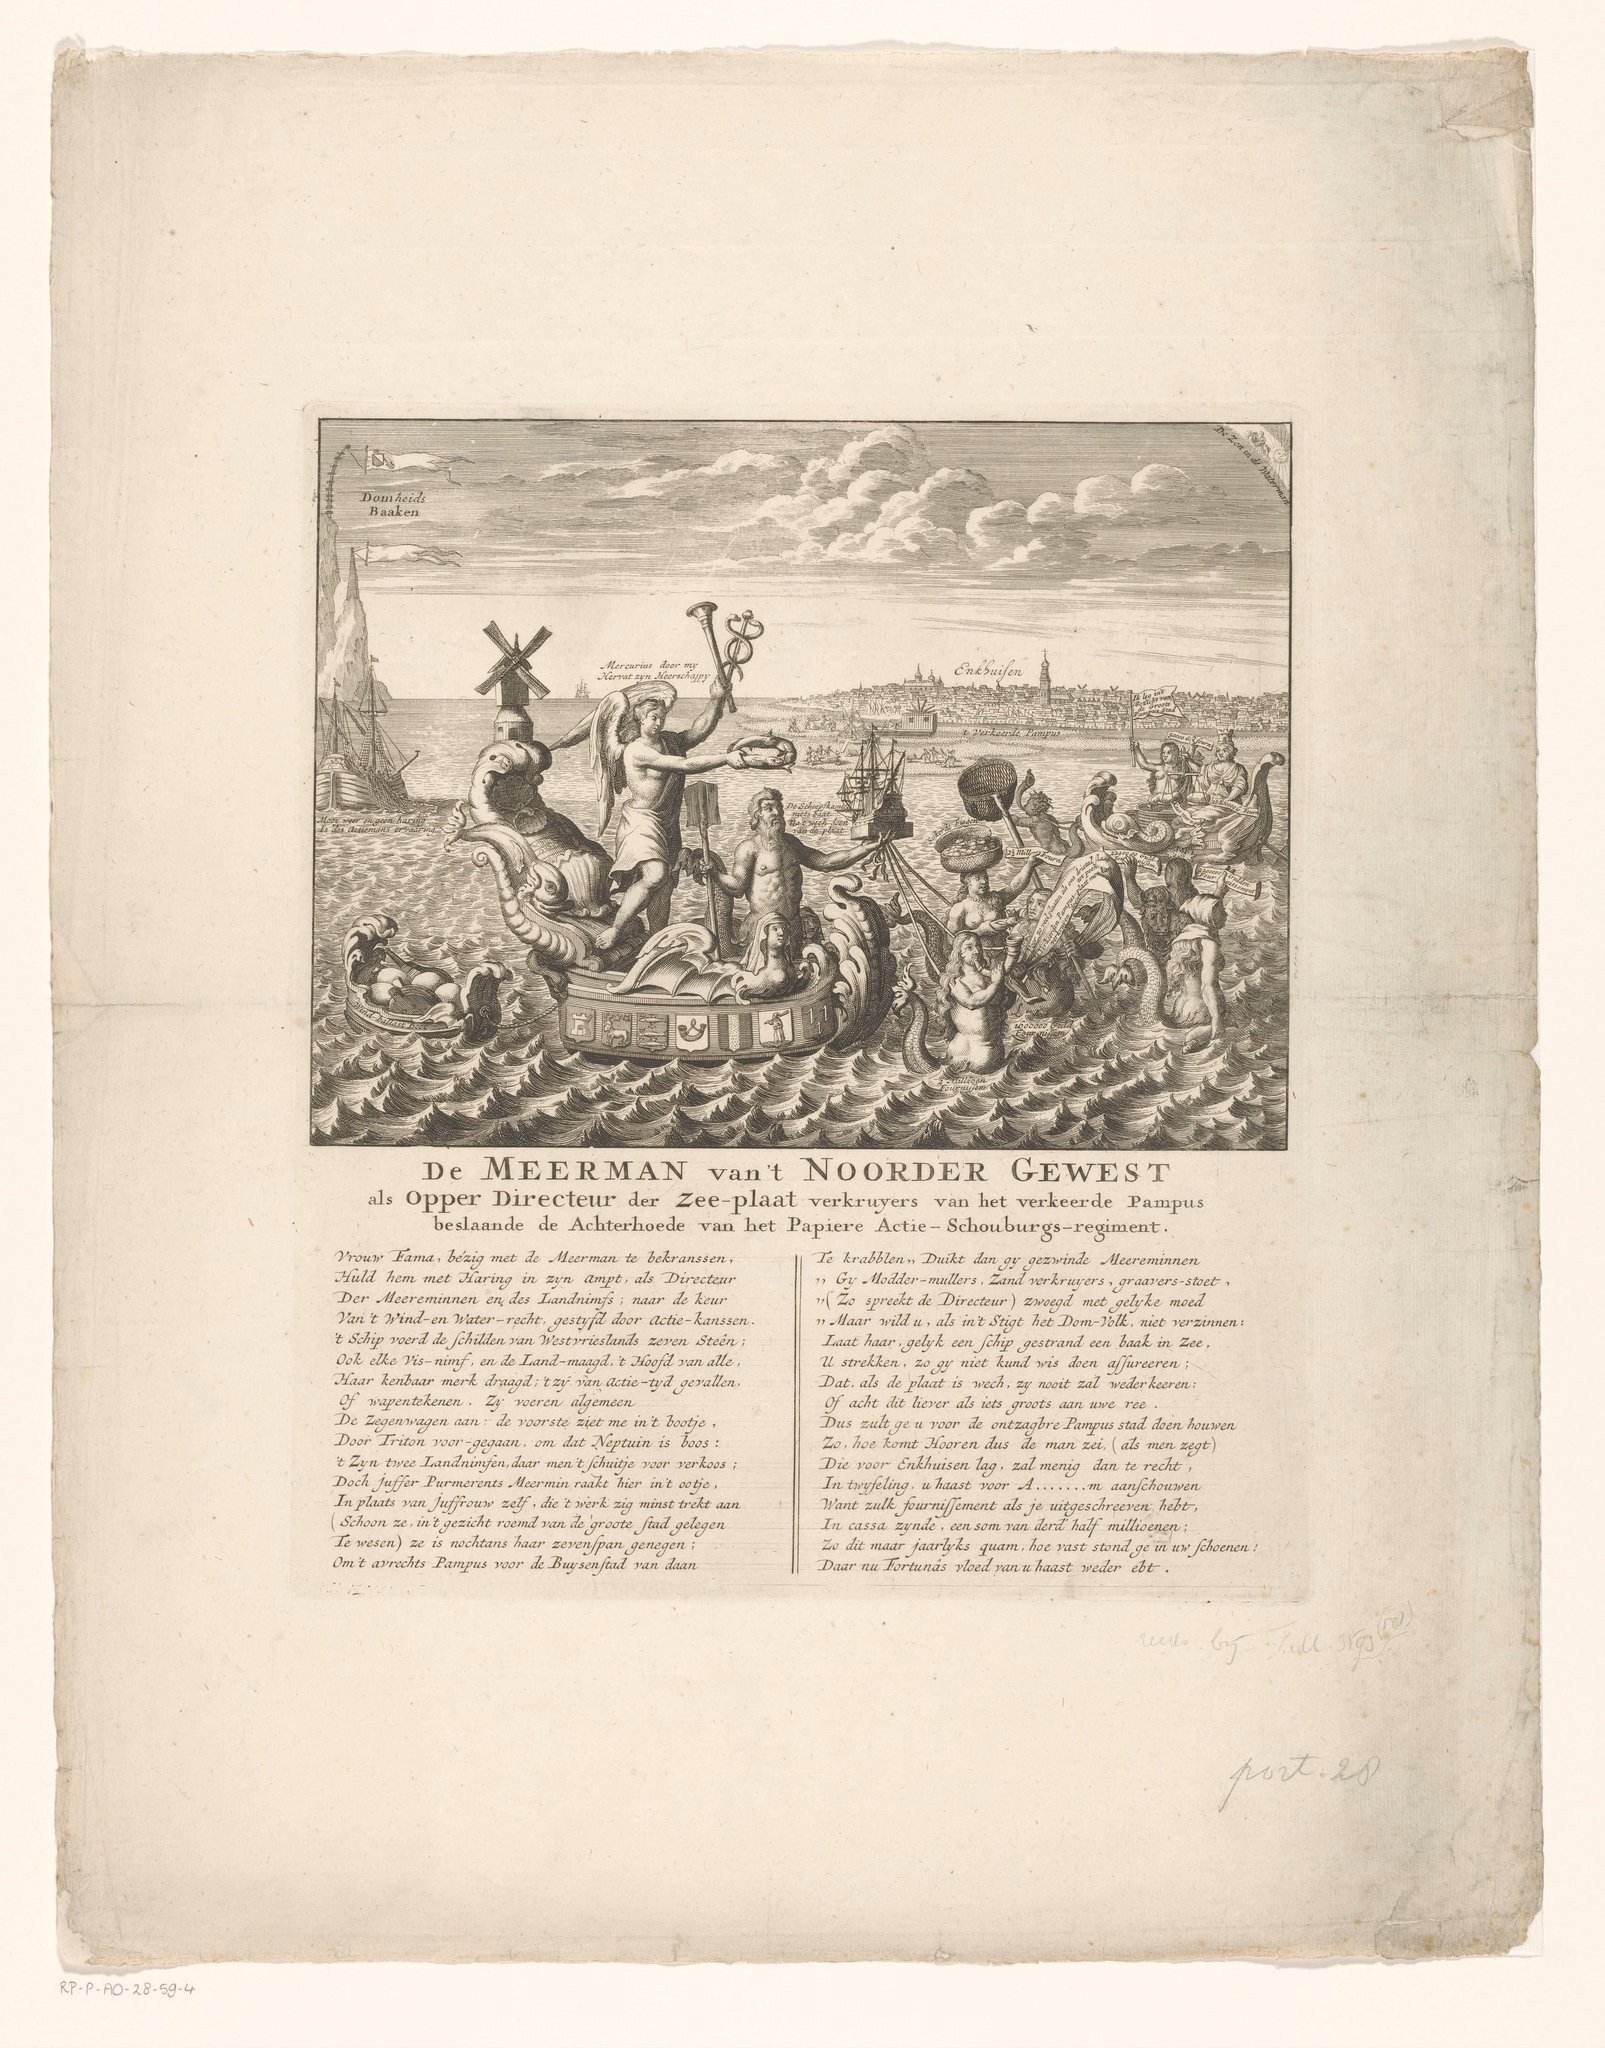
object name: cartoon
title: De Meerman van 't Noorder Gewest als Opper Directeur der Zee-plaat verkruyers van het verkeerde Pampus beslaande de Achterhoede van het Papiere Actie-Schouburgs-regiment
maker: Anonymous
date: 1720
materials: paper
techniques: engraving, etching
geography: northern netherlands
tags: merman, fame; 'fama', 'fama buona', 'fama chiara' (ripa), enkhuizen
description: Schuitje versierd met de wapens van de zeven steden van het Noorderkwartier waarin een meerman gekroond wordt door de Faam, de boot wordt getrokken door zeemeerminnen. In het verschiet Enkhuizen waar de actionisten in 1720 een haven wilden aanleggen. Met onderschrift in twee kolommen. Prent 58 in de serie Het Groote Tafereel der Dwaasheid met spotprenten op de Windhandel of Actiehandel van 1720.